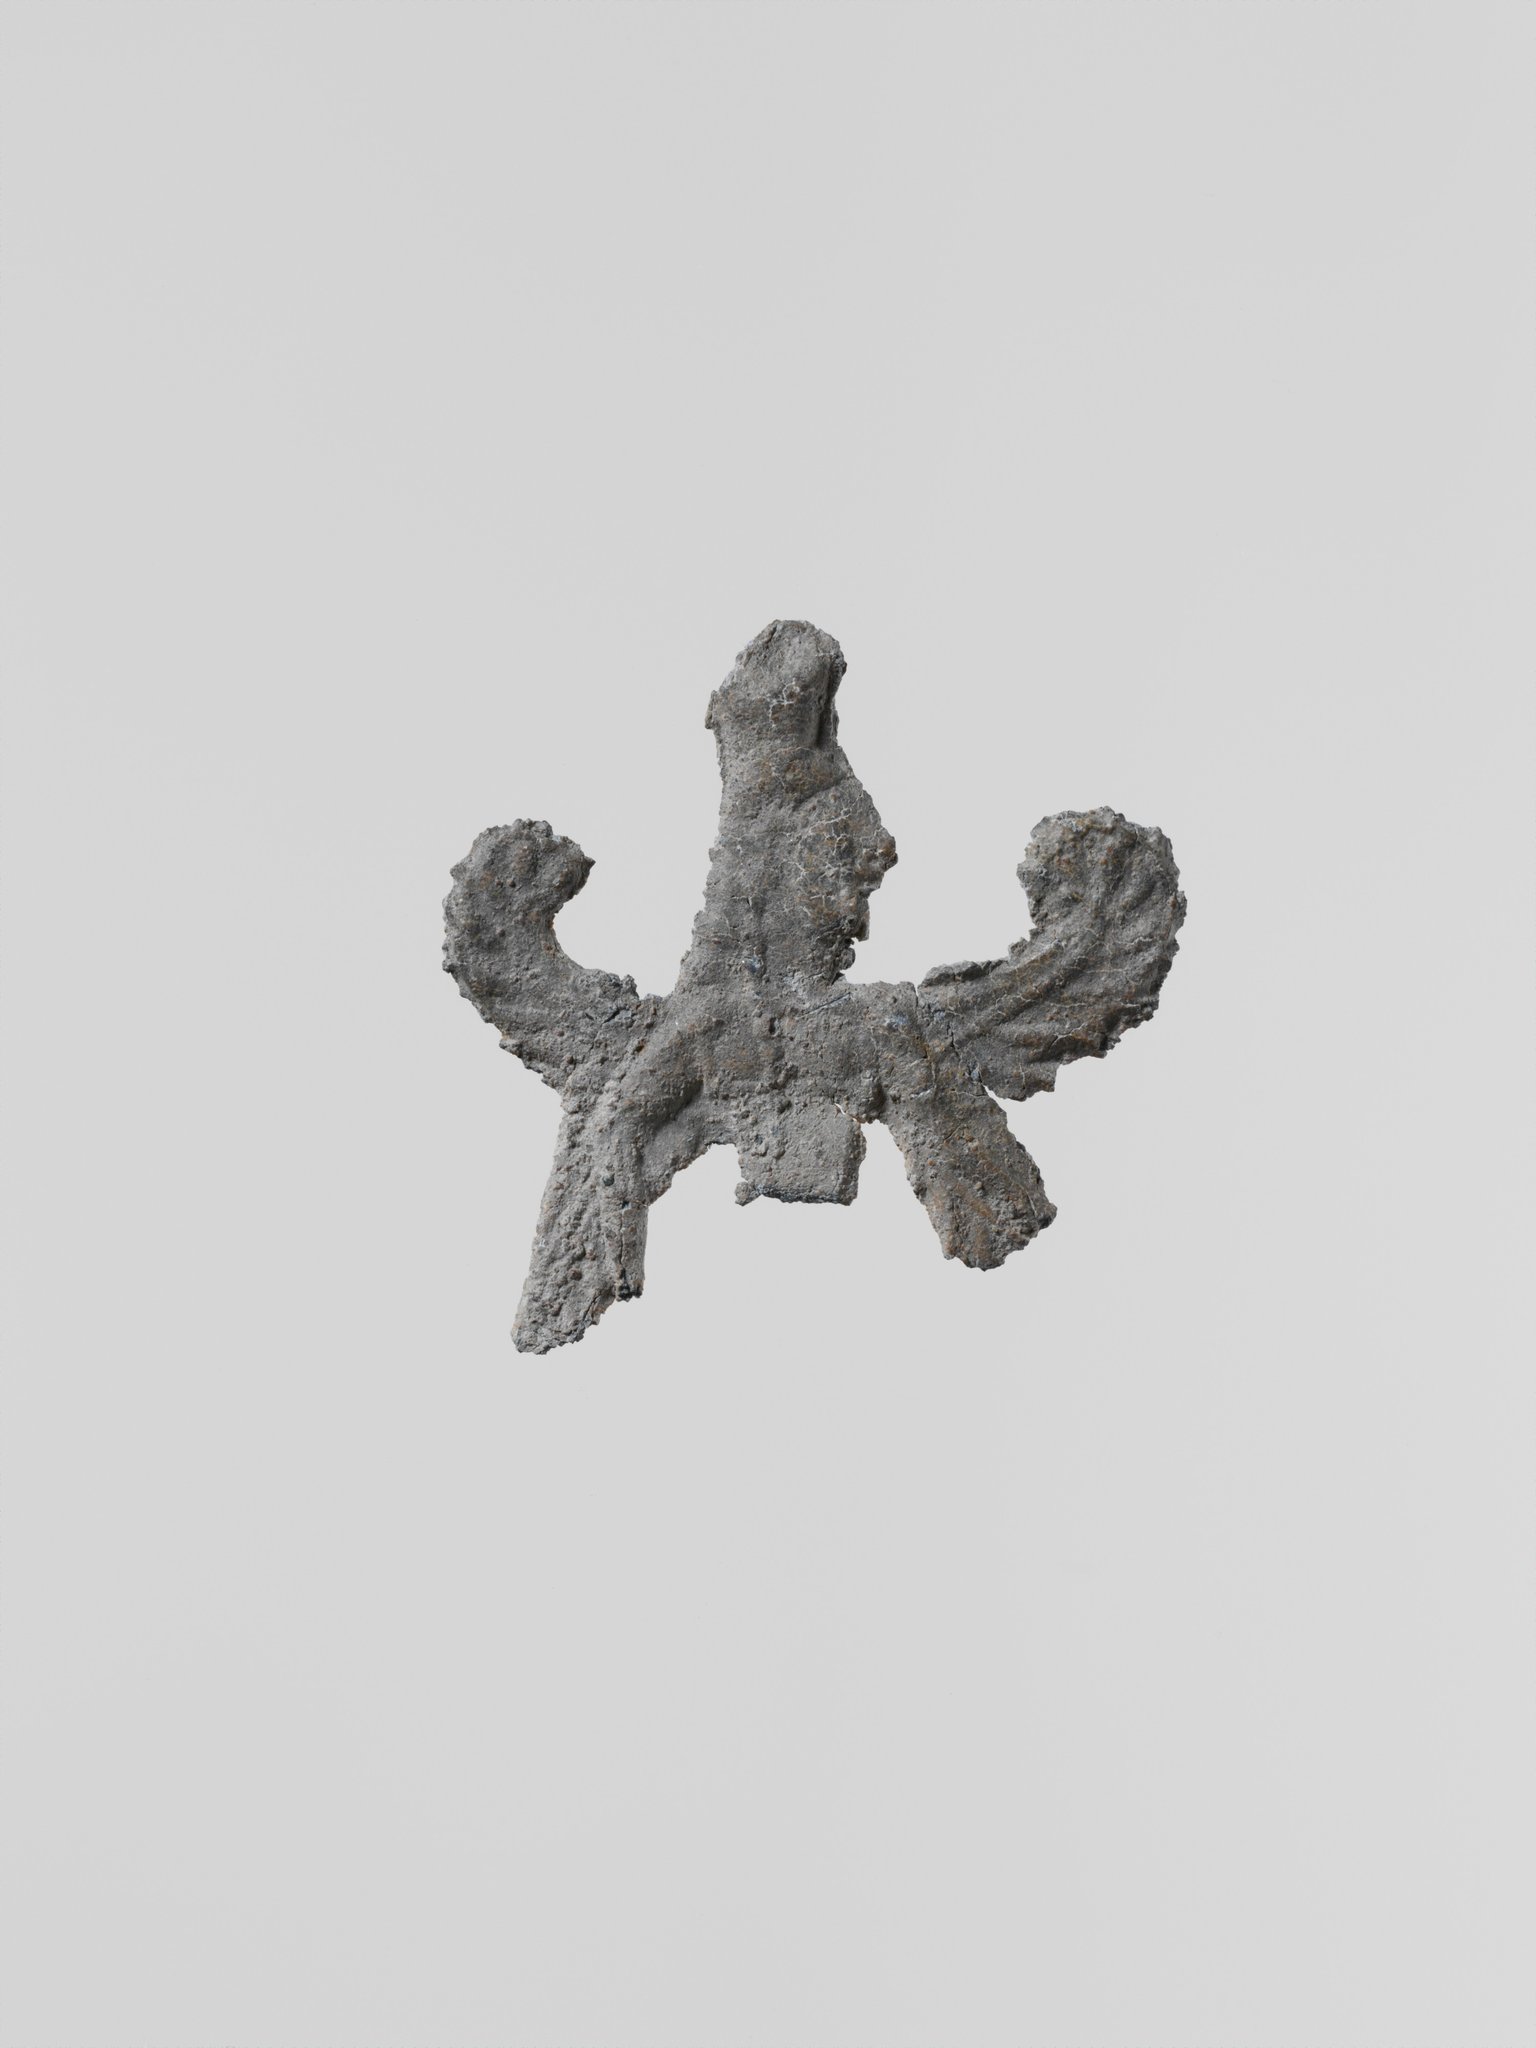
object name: statuette of artemis orthia winged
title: Lead figure of a winged goddess, possibly Artemis Orthia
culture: greek, laconian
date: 634-501 BCE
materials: lead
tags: artemis,goddess